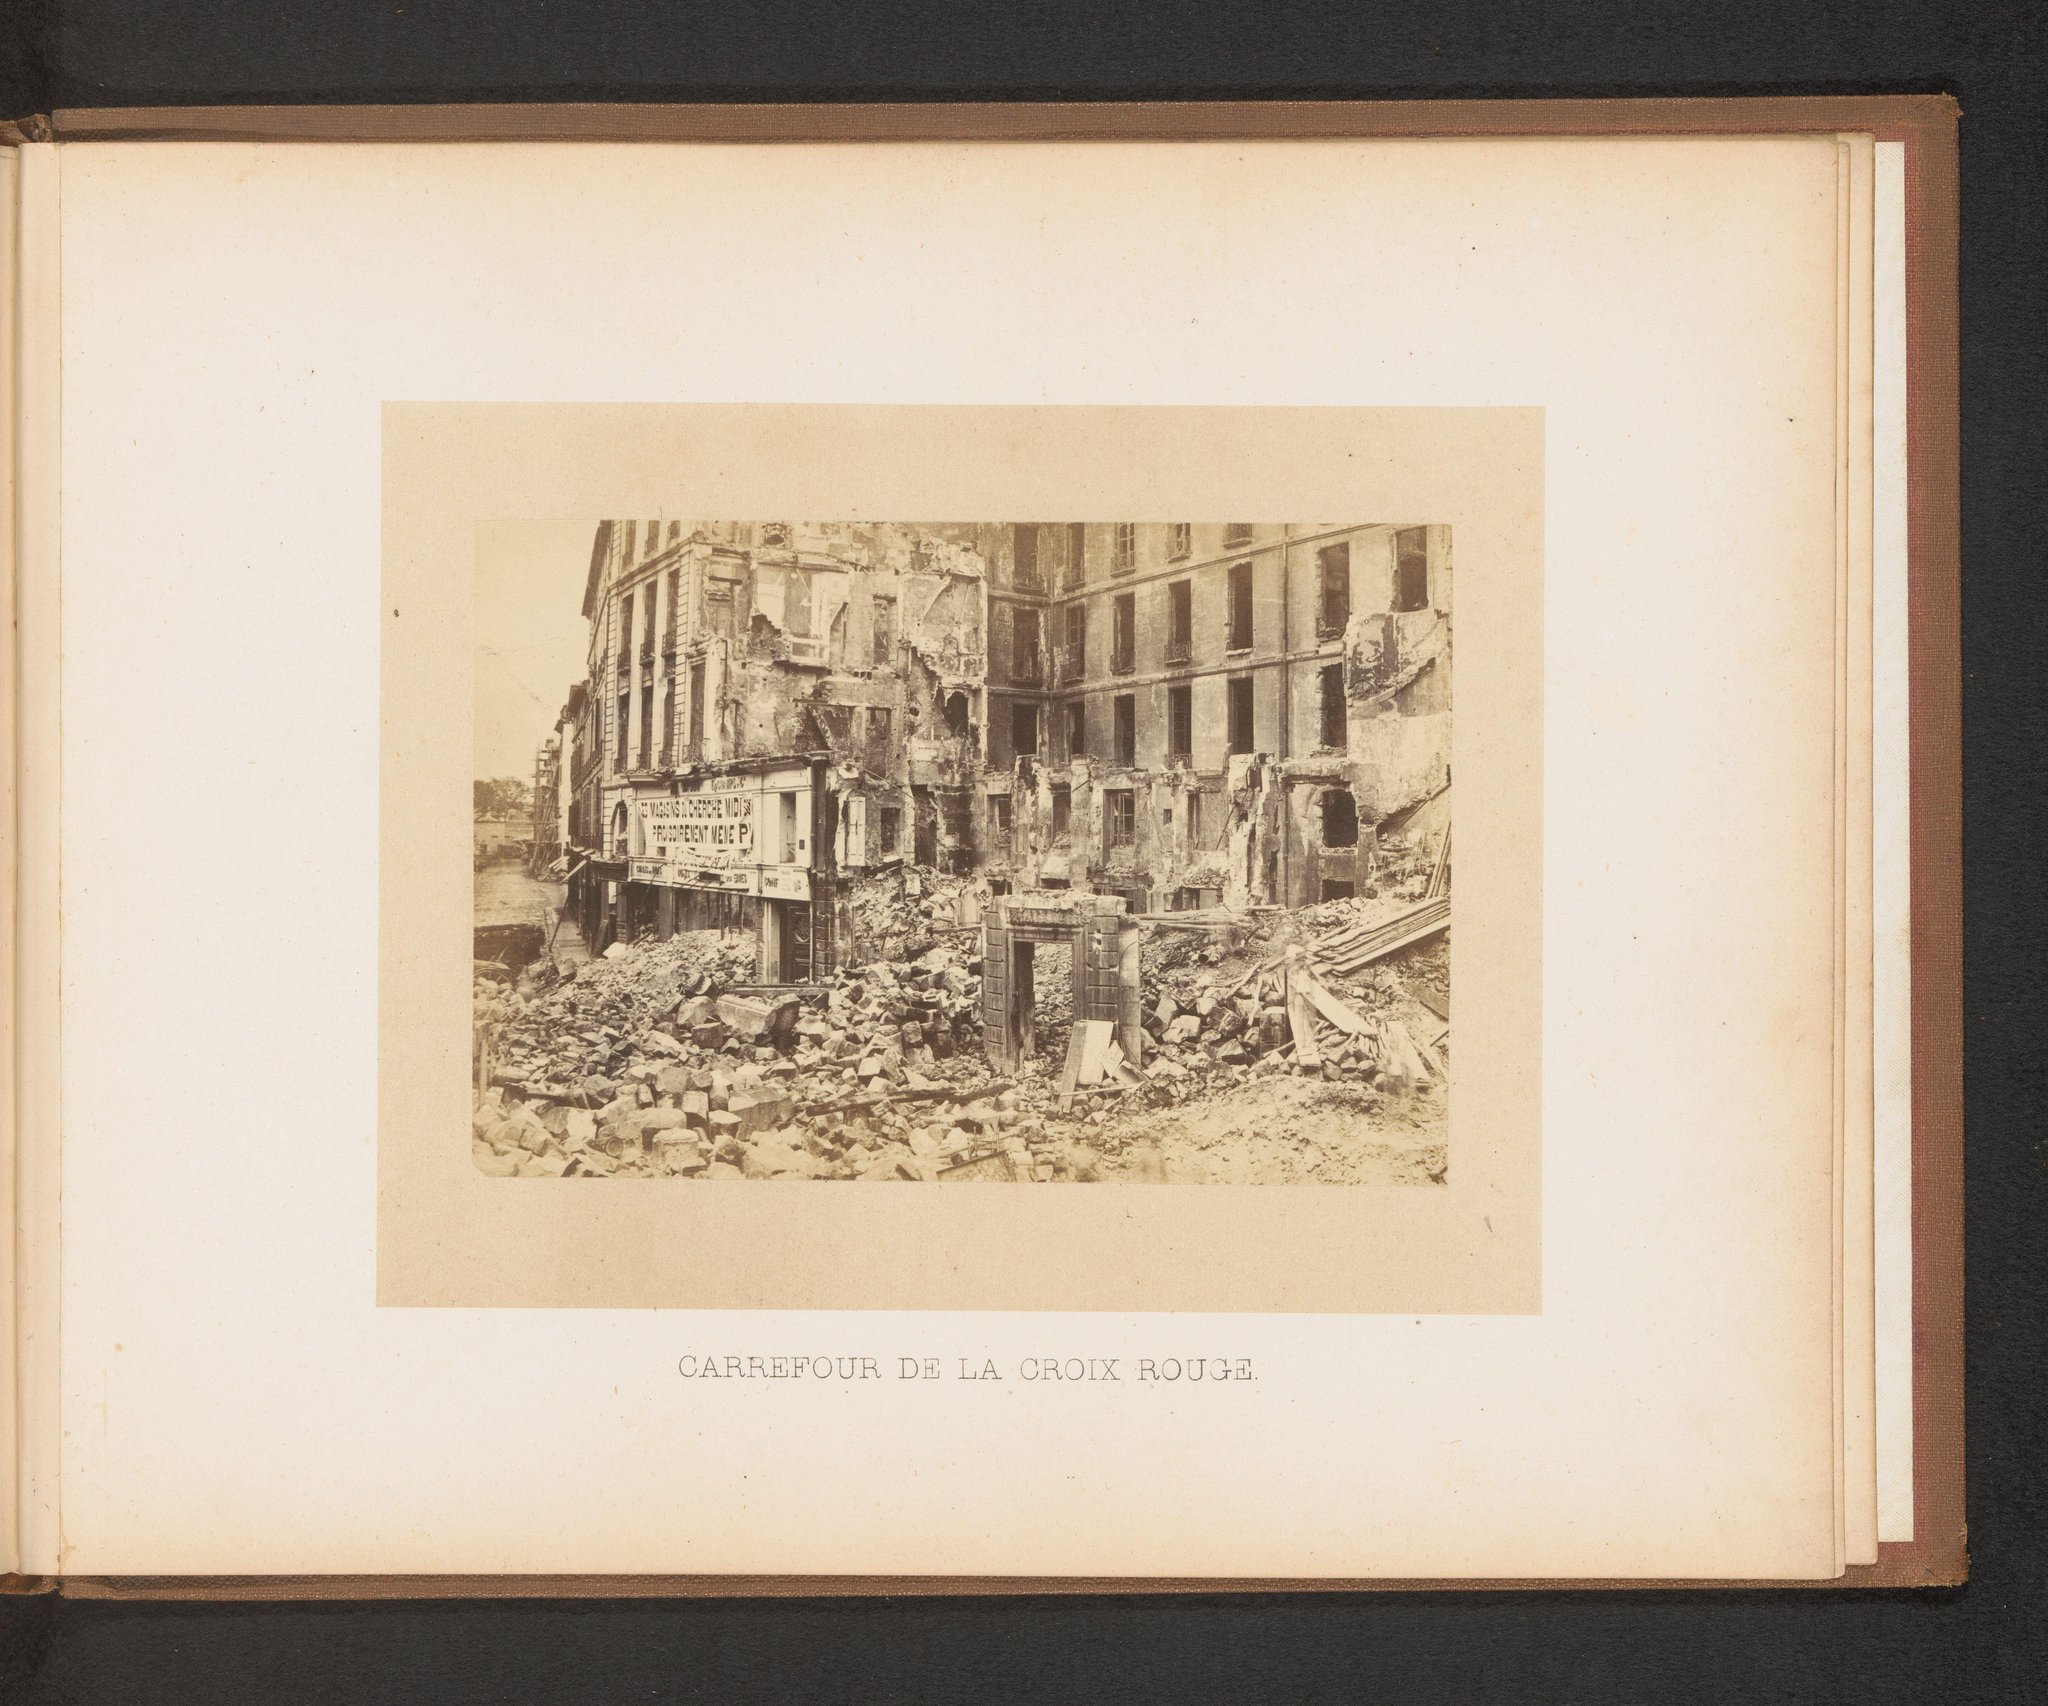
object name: photograph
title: Carrefour de la Croix Rouge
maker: Anonymous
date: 1871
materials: photographic support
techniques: albumen print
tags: theatre (building), street, paris